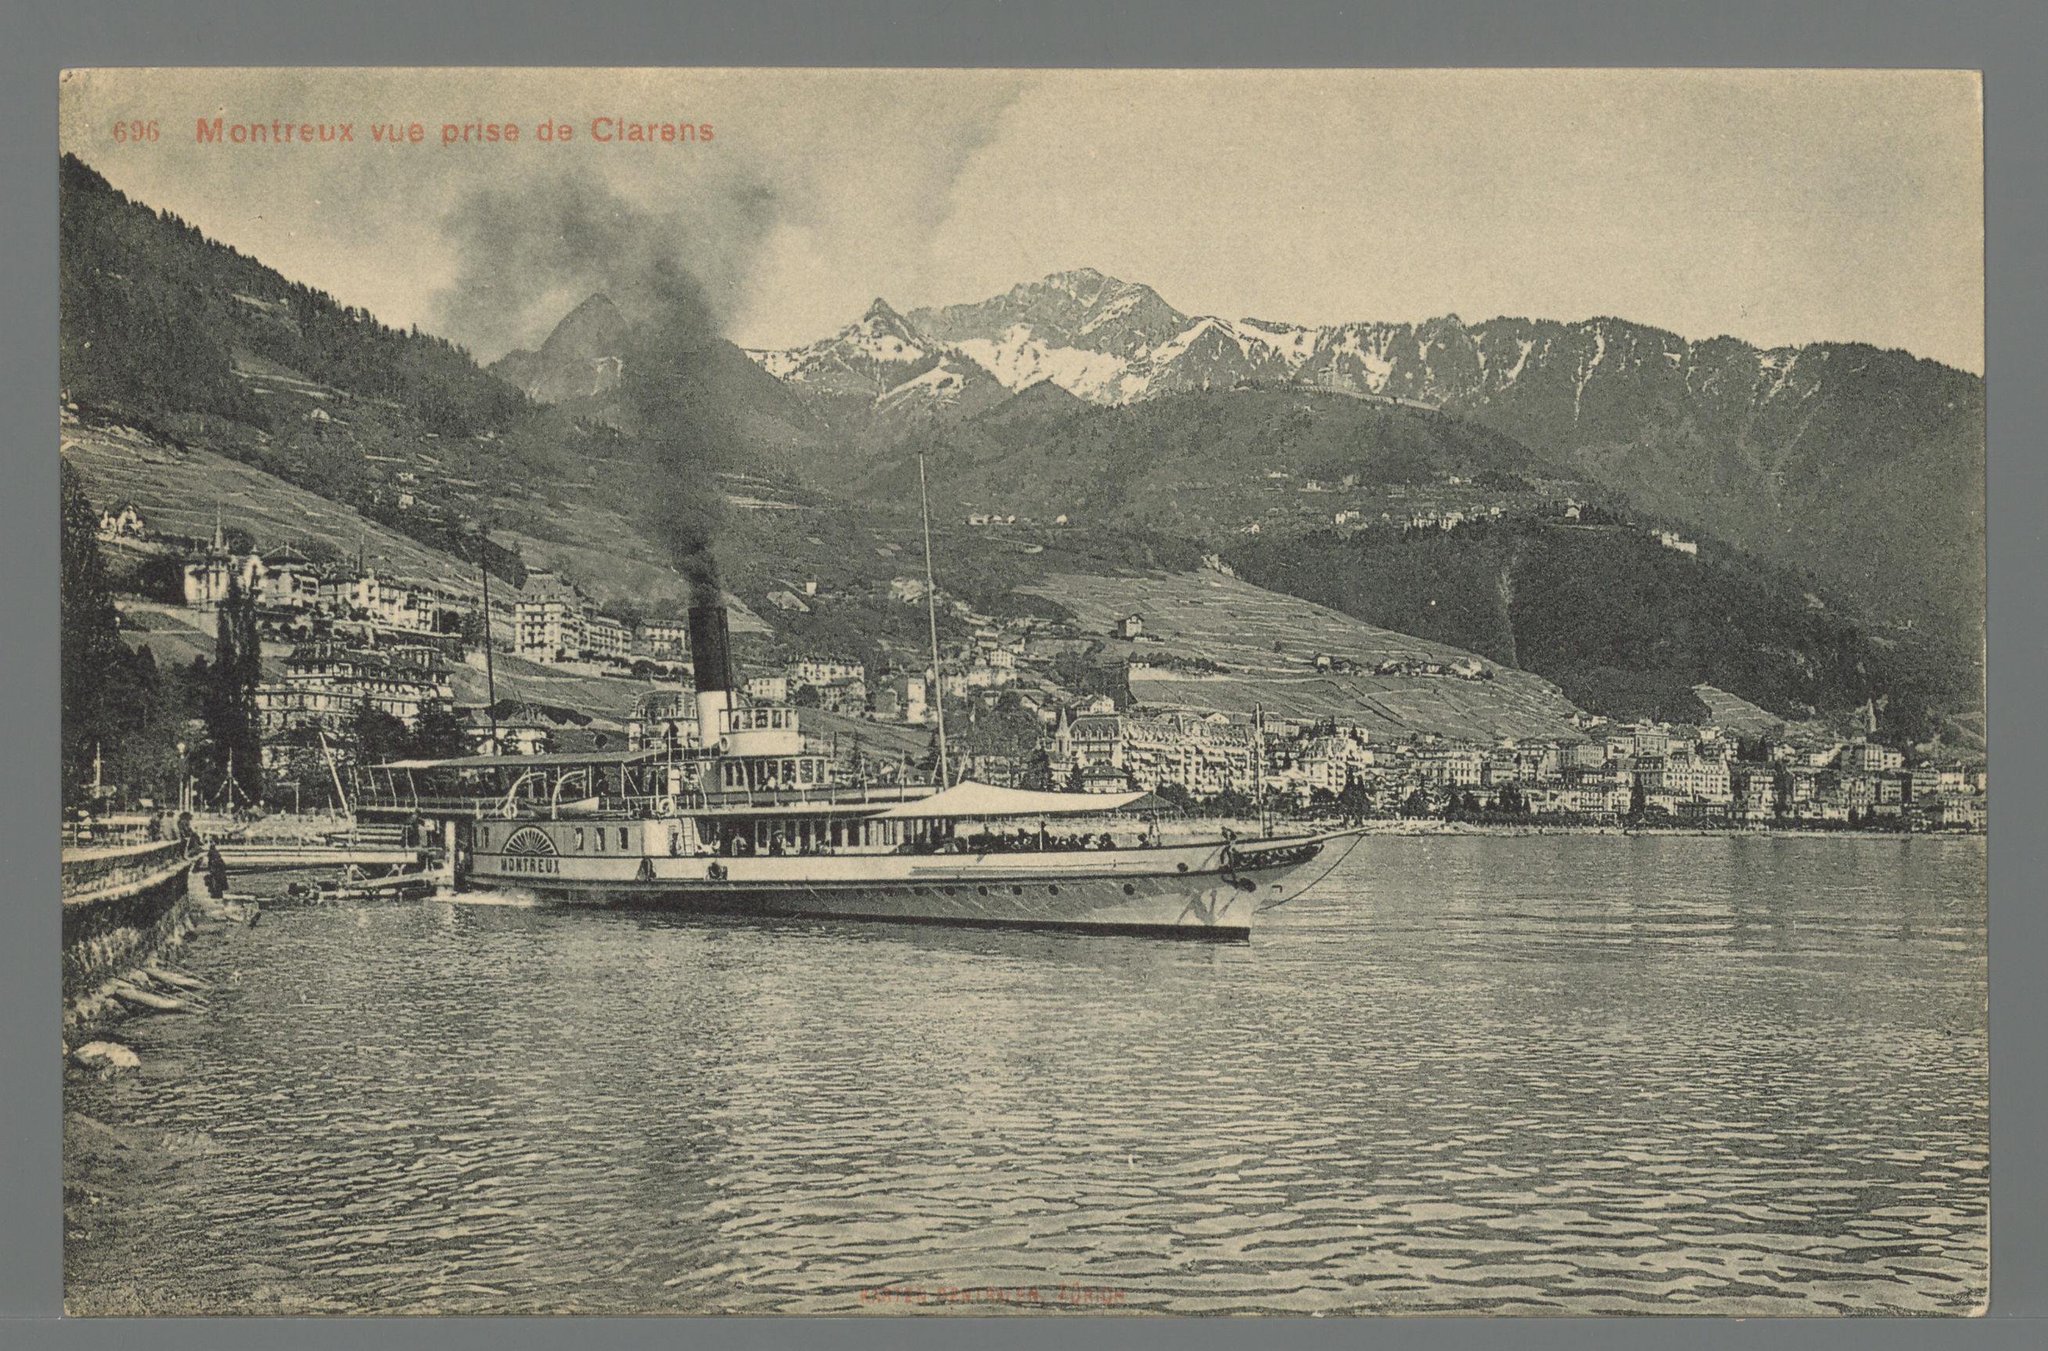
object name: ansichtkaart, prentbriefkaart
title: Montreux, vue prise de Clarens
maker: Anonymous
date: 1905-1909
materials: cardboard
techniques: photograph, writing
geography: montreux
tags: mountain-range, snow peaks, lake (+ landscape with figures, staffage), prospect of city, town panorama, silhouette of city